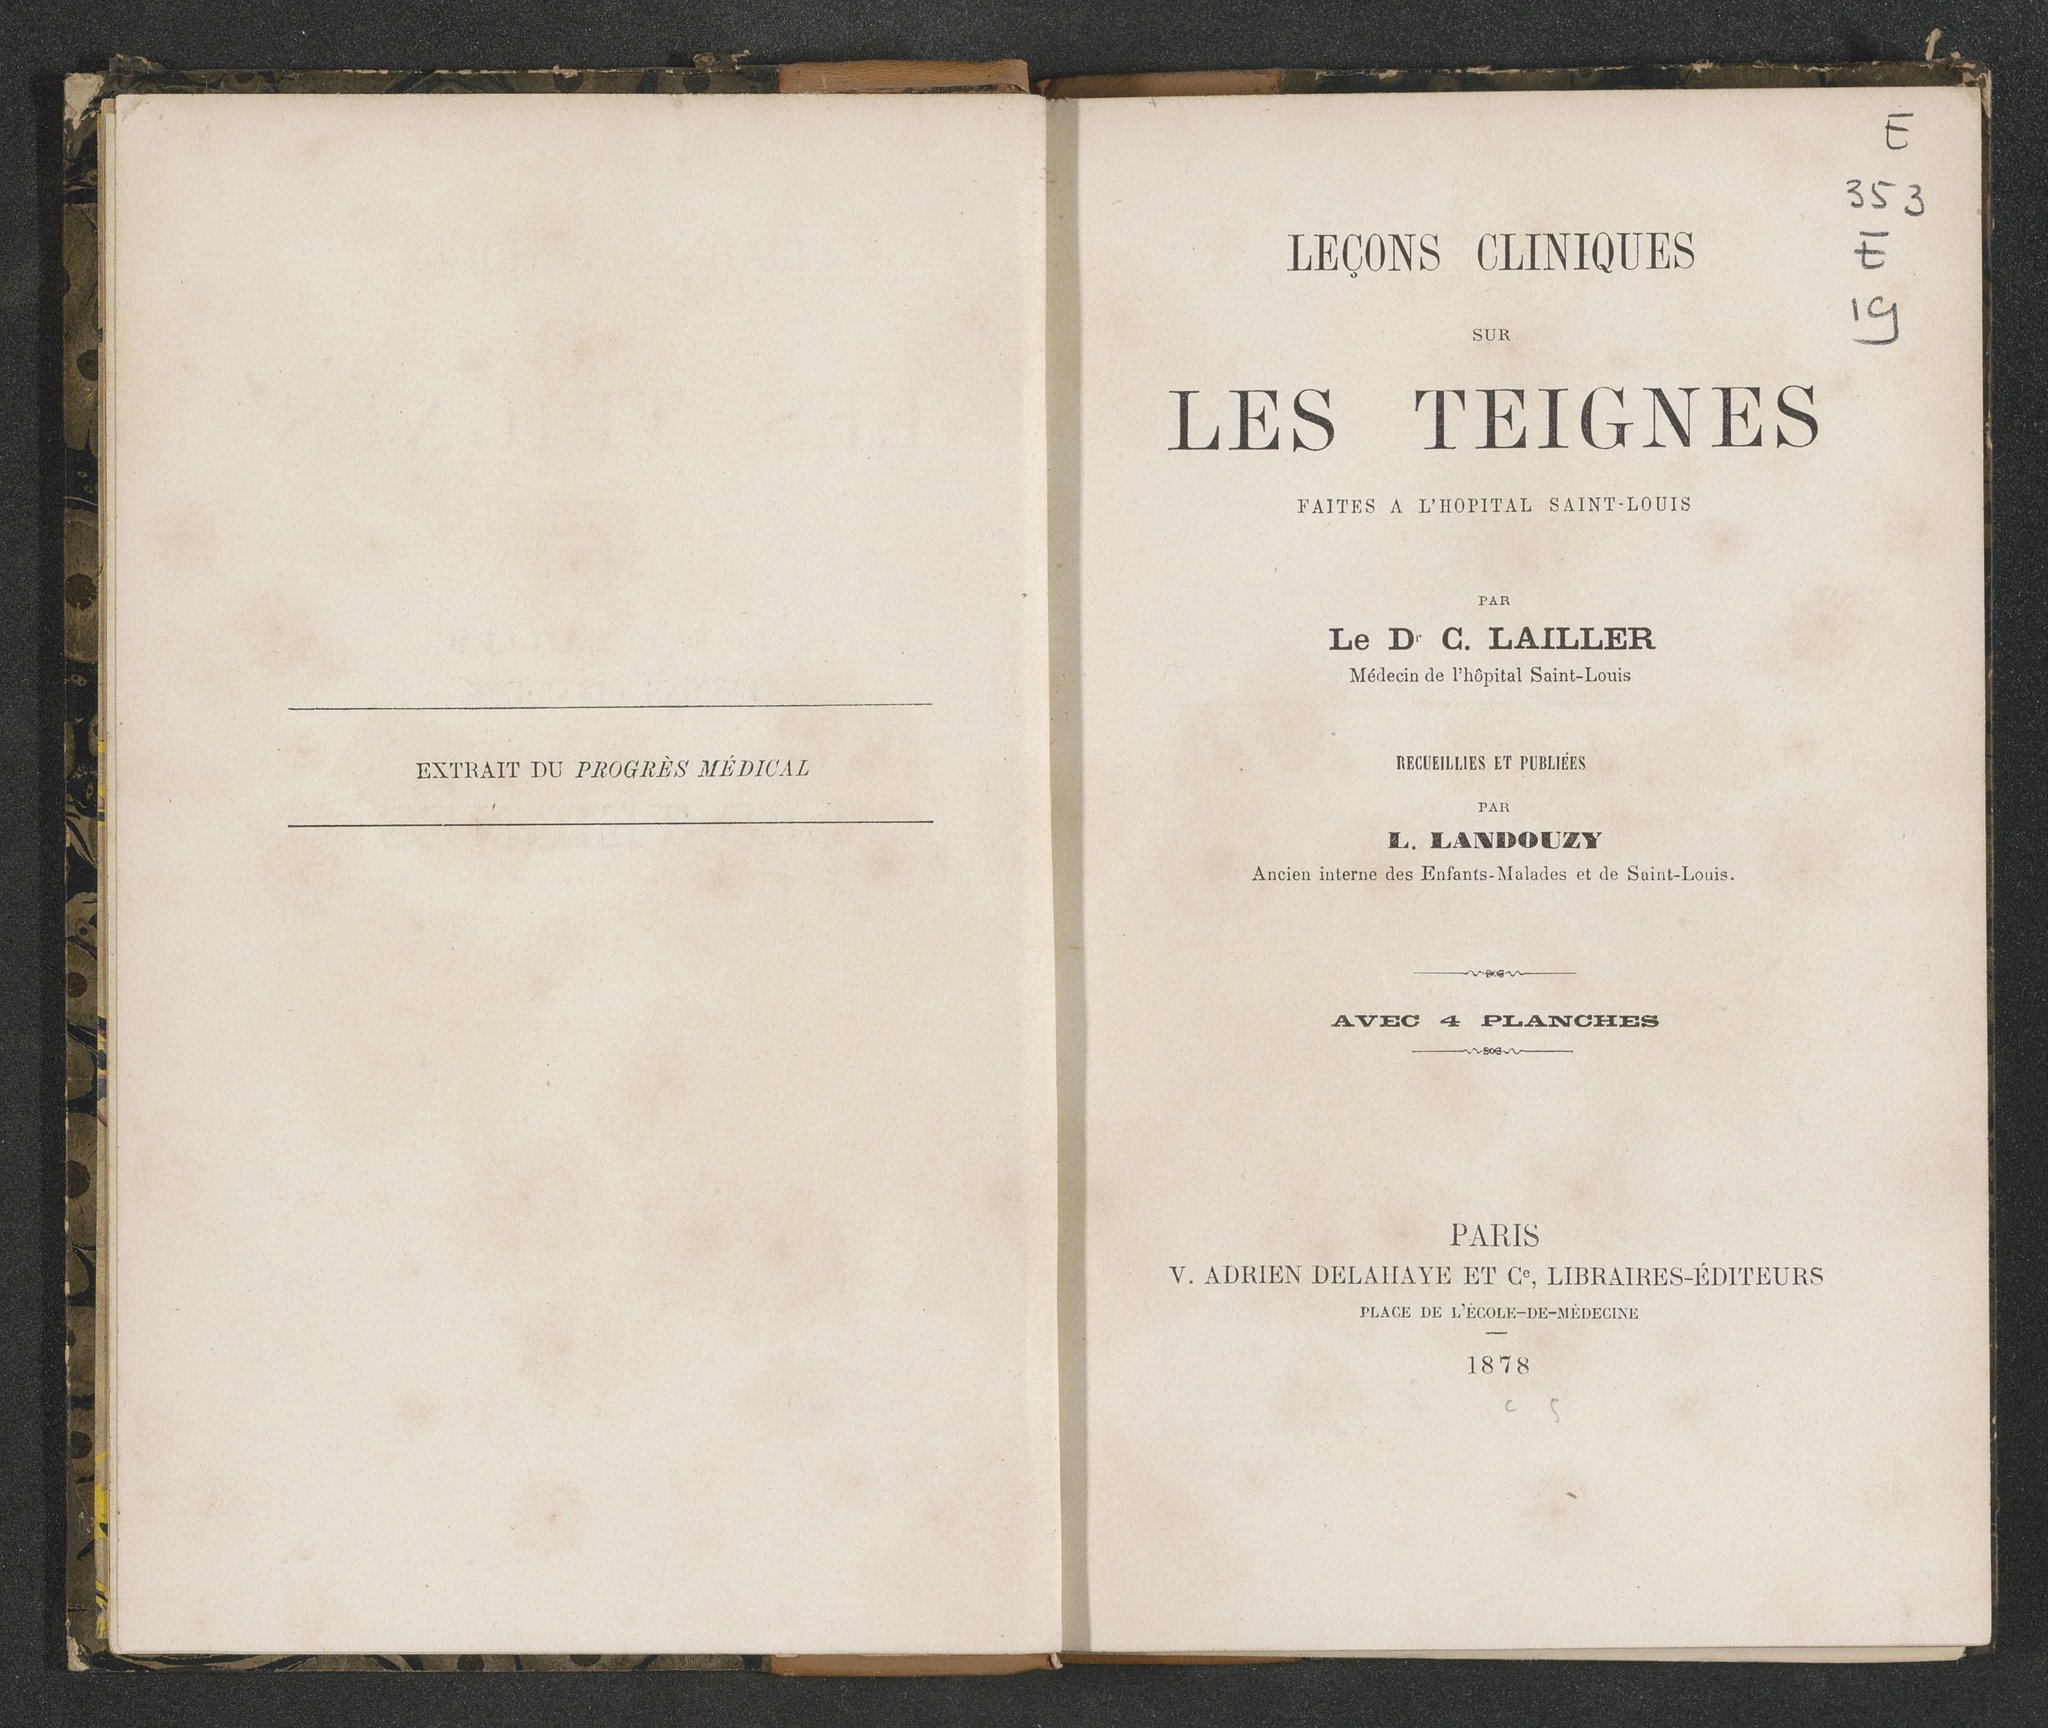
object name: book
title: Leçons cliniques sur les teignes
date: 1878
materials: leather, paper, photographic process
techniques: printing, marbled paper, marbling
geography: paris